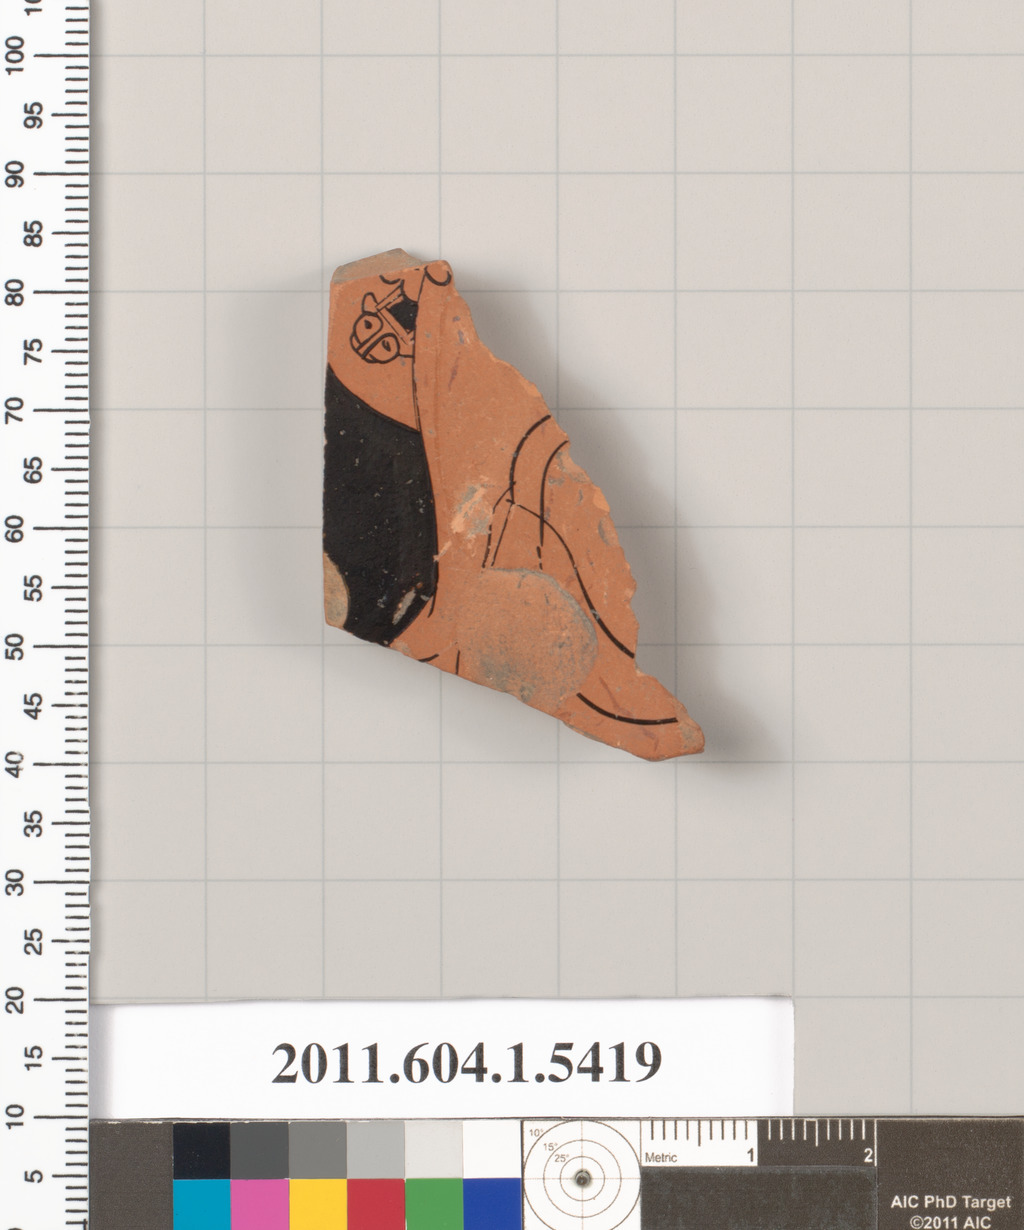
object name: kylix fragment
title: Terracotta fragment of a kylix (drinking cup)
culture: greek, attic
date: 500-480 BCE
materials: terracotta